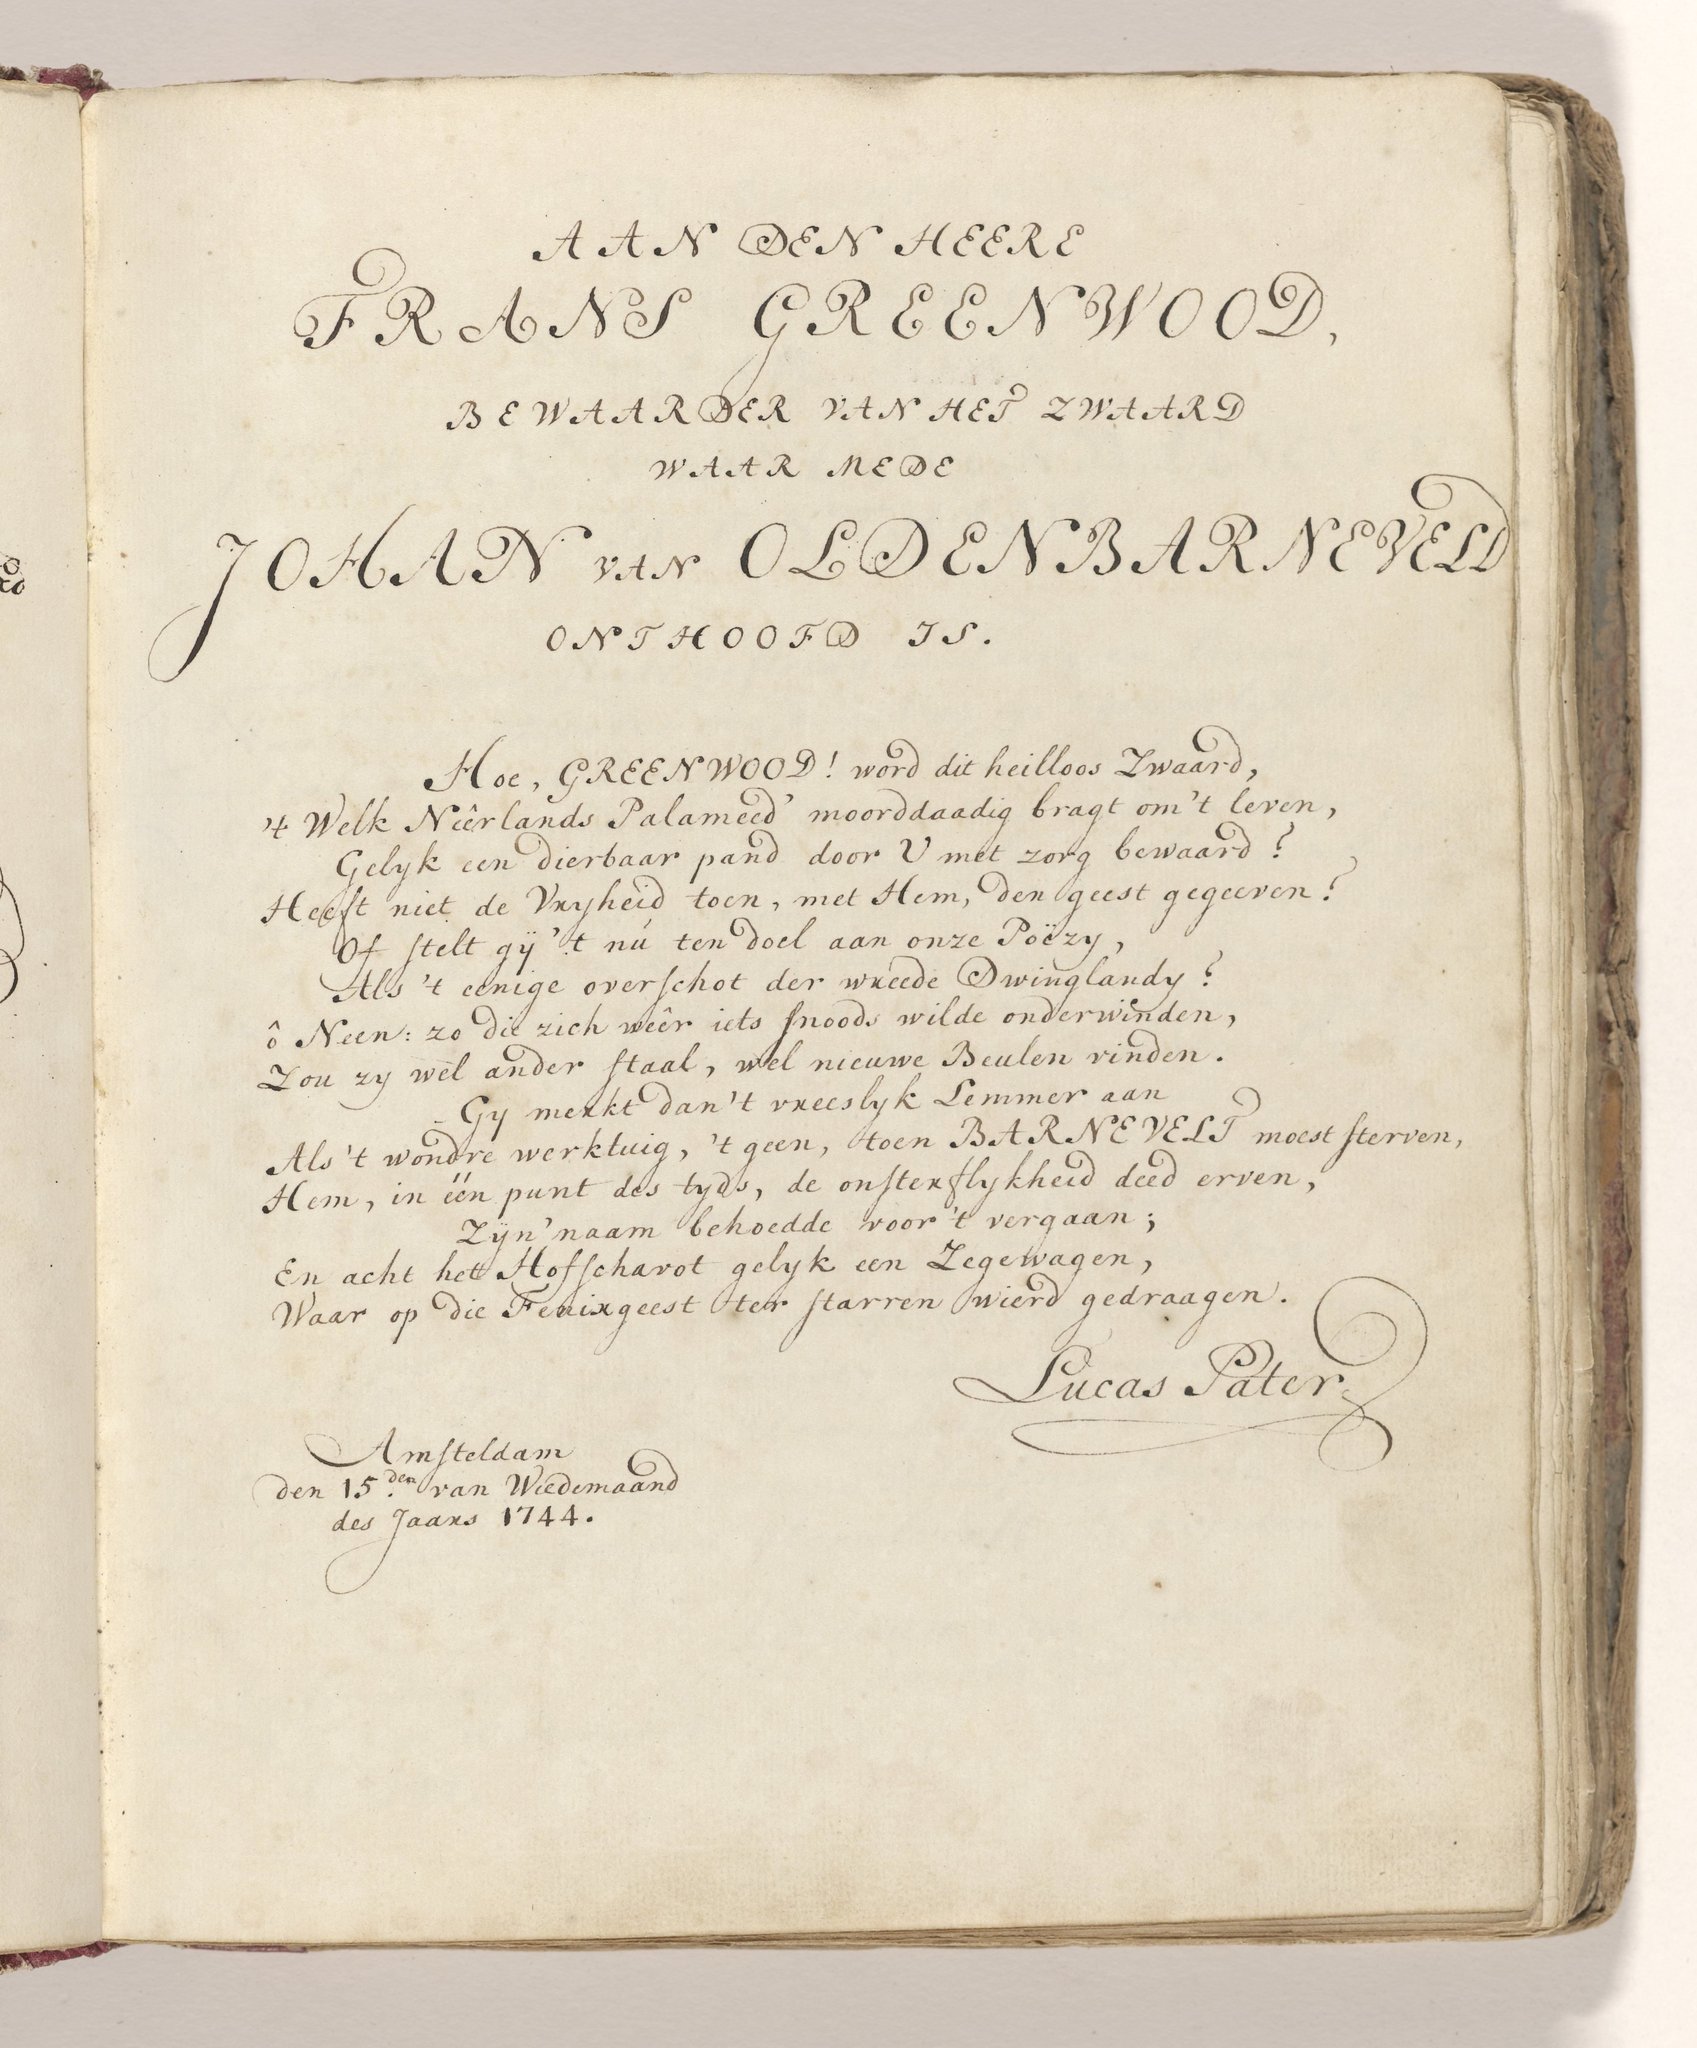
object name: manuscript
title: Aan den heere Frans Greenwood, bewaarder van het zwaard waar mede Johan van Oldenbarneveld onthoofd is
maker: lucas pater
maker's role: schrijver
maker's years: 1707-1781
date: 1744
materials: ink, paper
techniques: writing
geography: amsterdam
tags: the hague, johan van oldenbarnevelt, rotterdam, dordrecht, print maker, frans greenwood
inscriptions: date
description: Vers van Lucas Pater. Onderdeel van het boek met gedichten uit de jaren 1743-1745 op het zwaard waarmee Johan van Oldenbarnevelt in 1619 zou zijn onthoofd. Het zwaard was eigendom van Frans Greenwood.